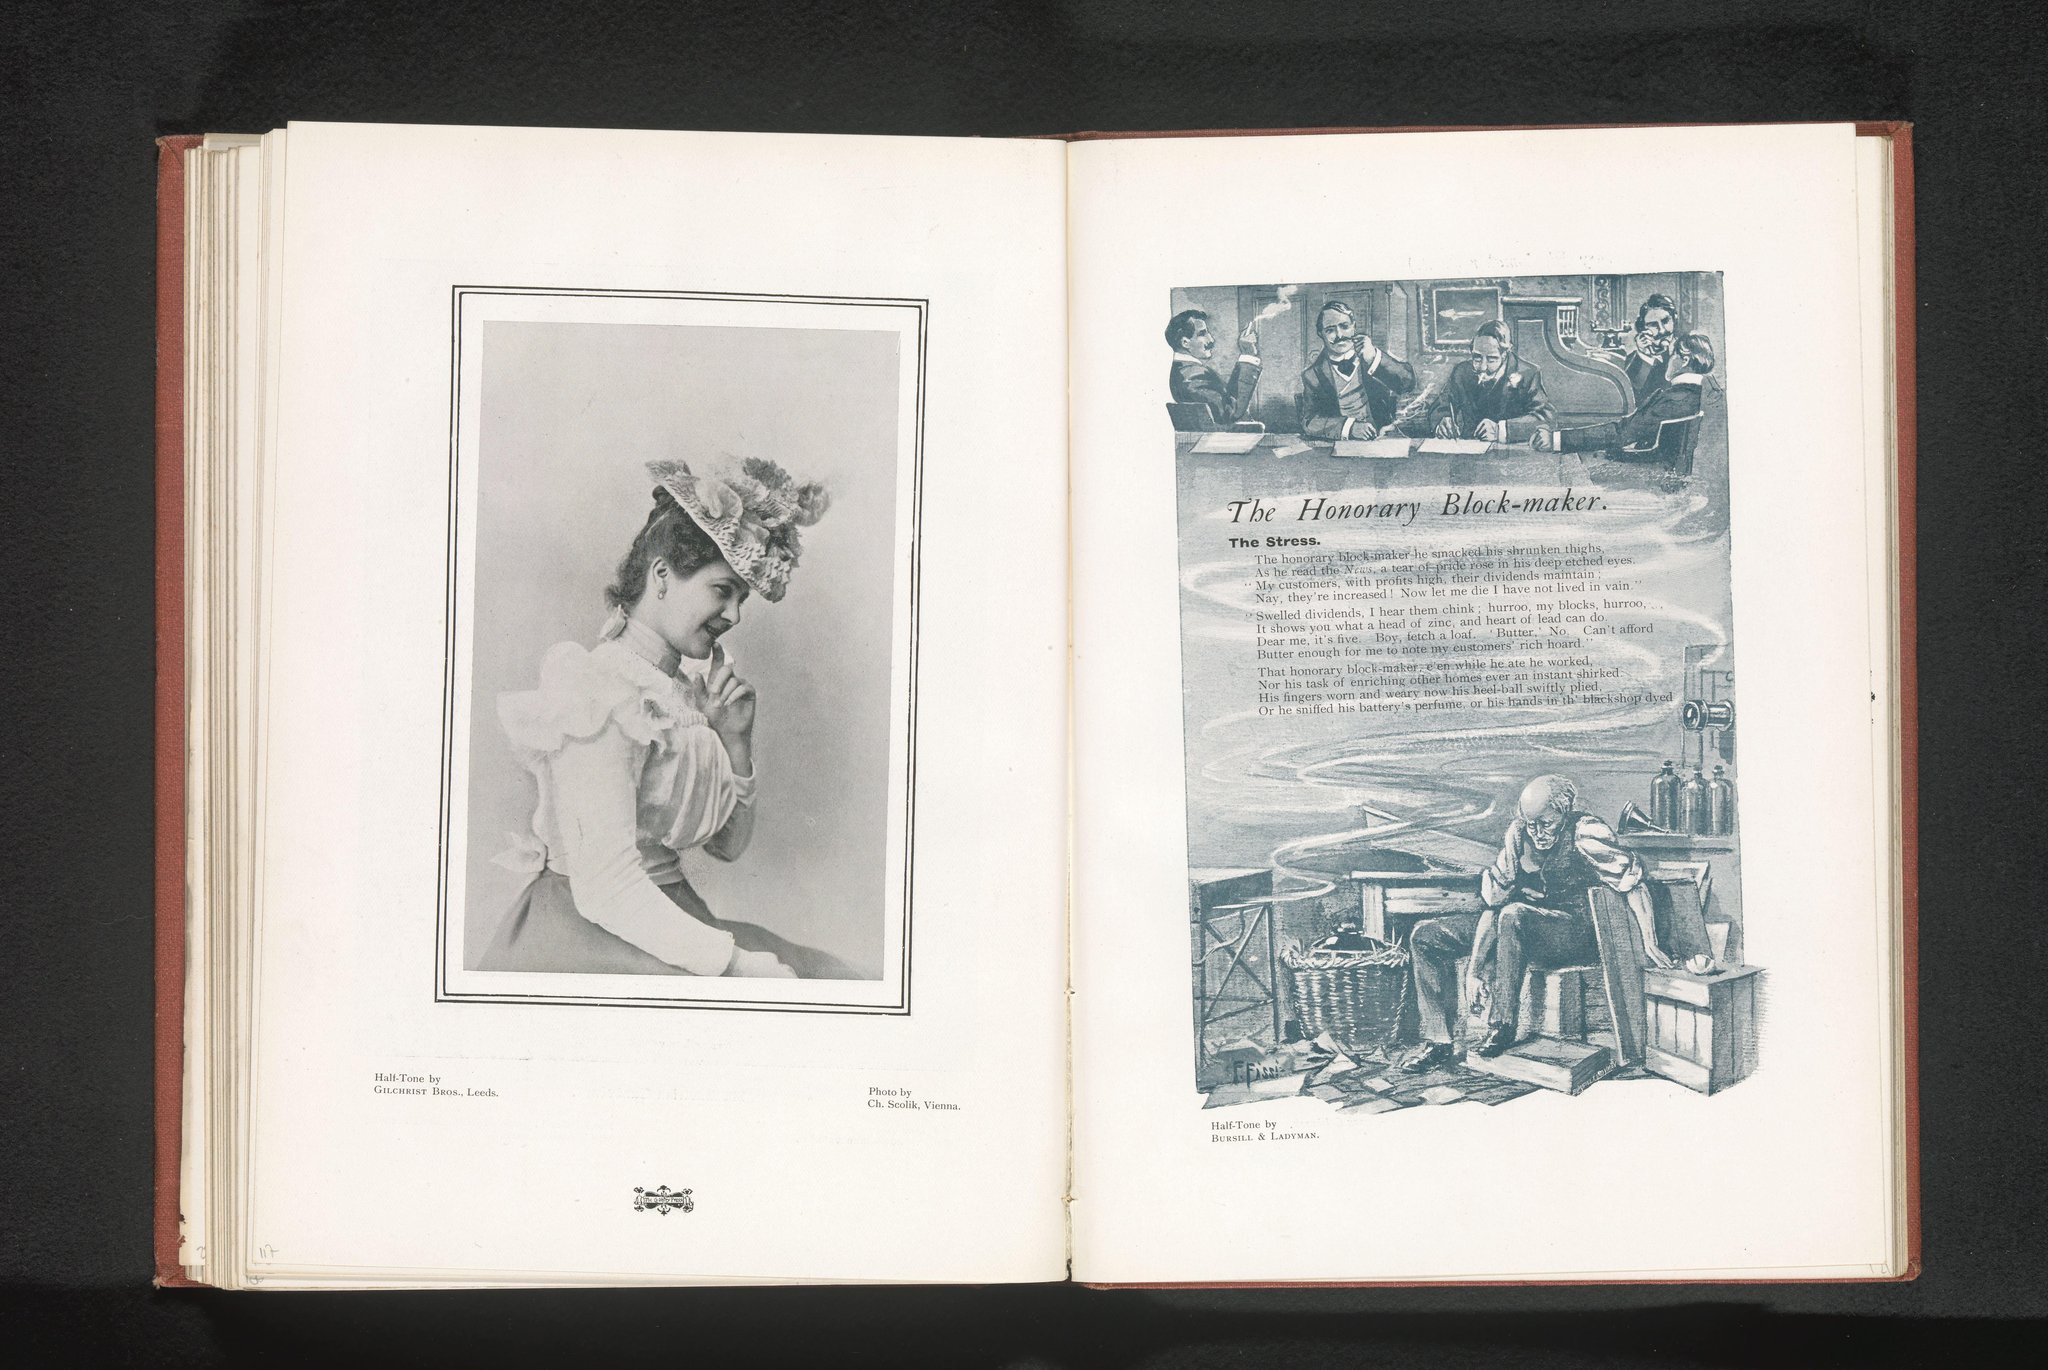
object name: photomechanical print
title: Portret van een onbekende jonge vrouw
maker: charles scolik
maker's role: chemicus, fotograaf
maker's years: 1853-1928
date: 1895-1900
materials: paper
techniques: autotype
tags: adolescent, young woman, maiden, historical persons - bb - woman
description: Prent op vierde ongenummerde pagina na pagina 96.